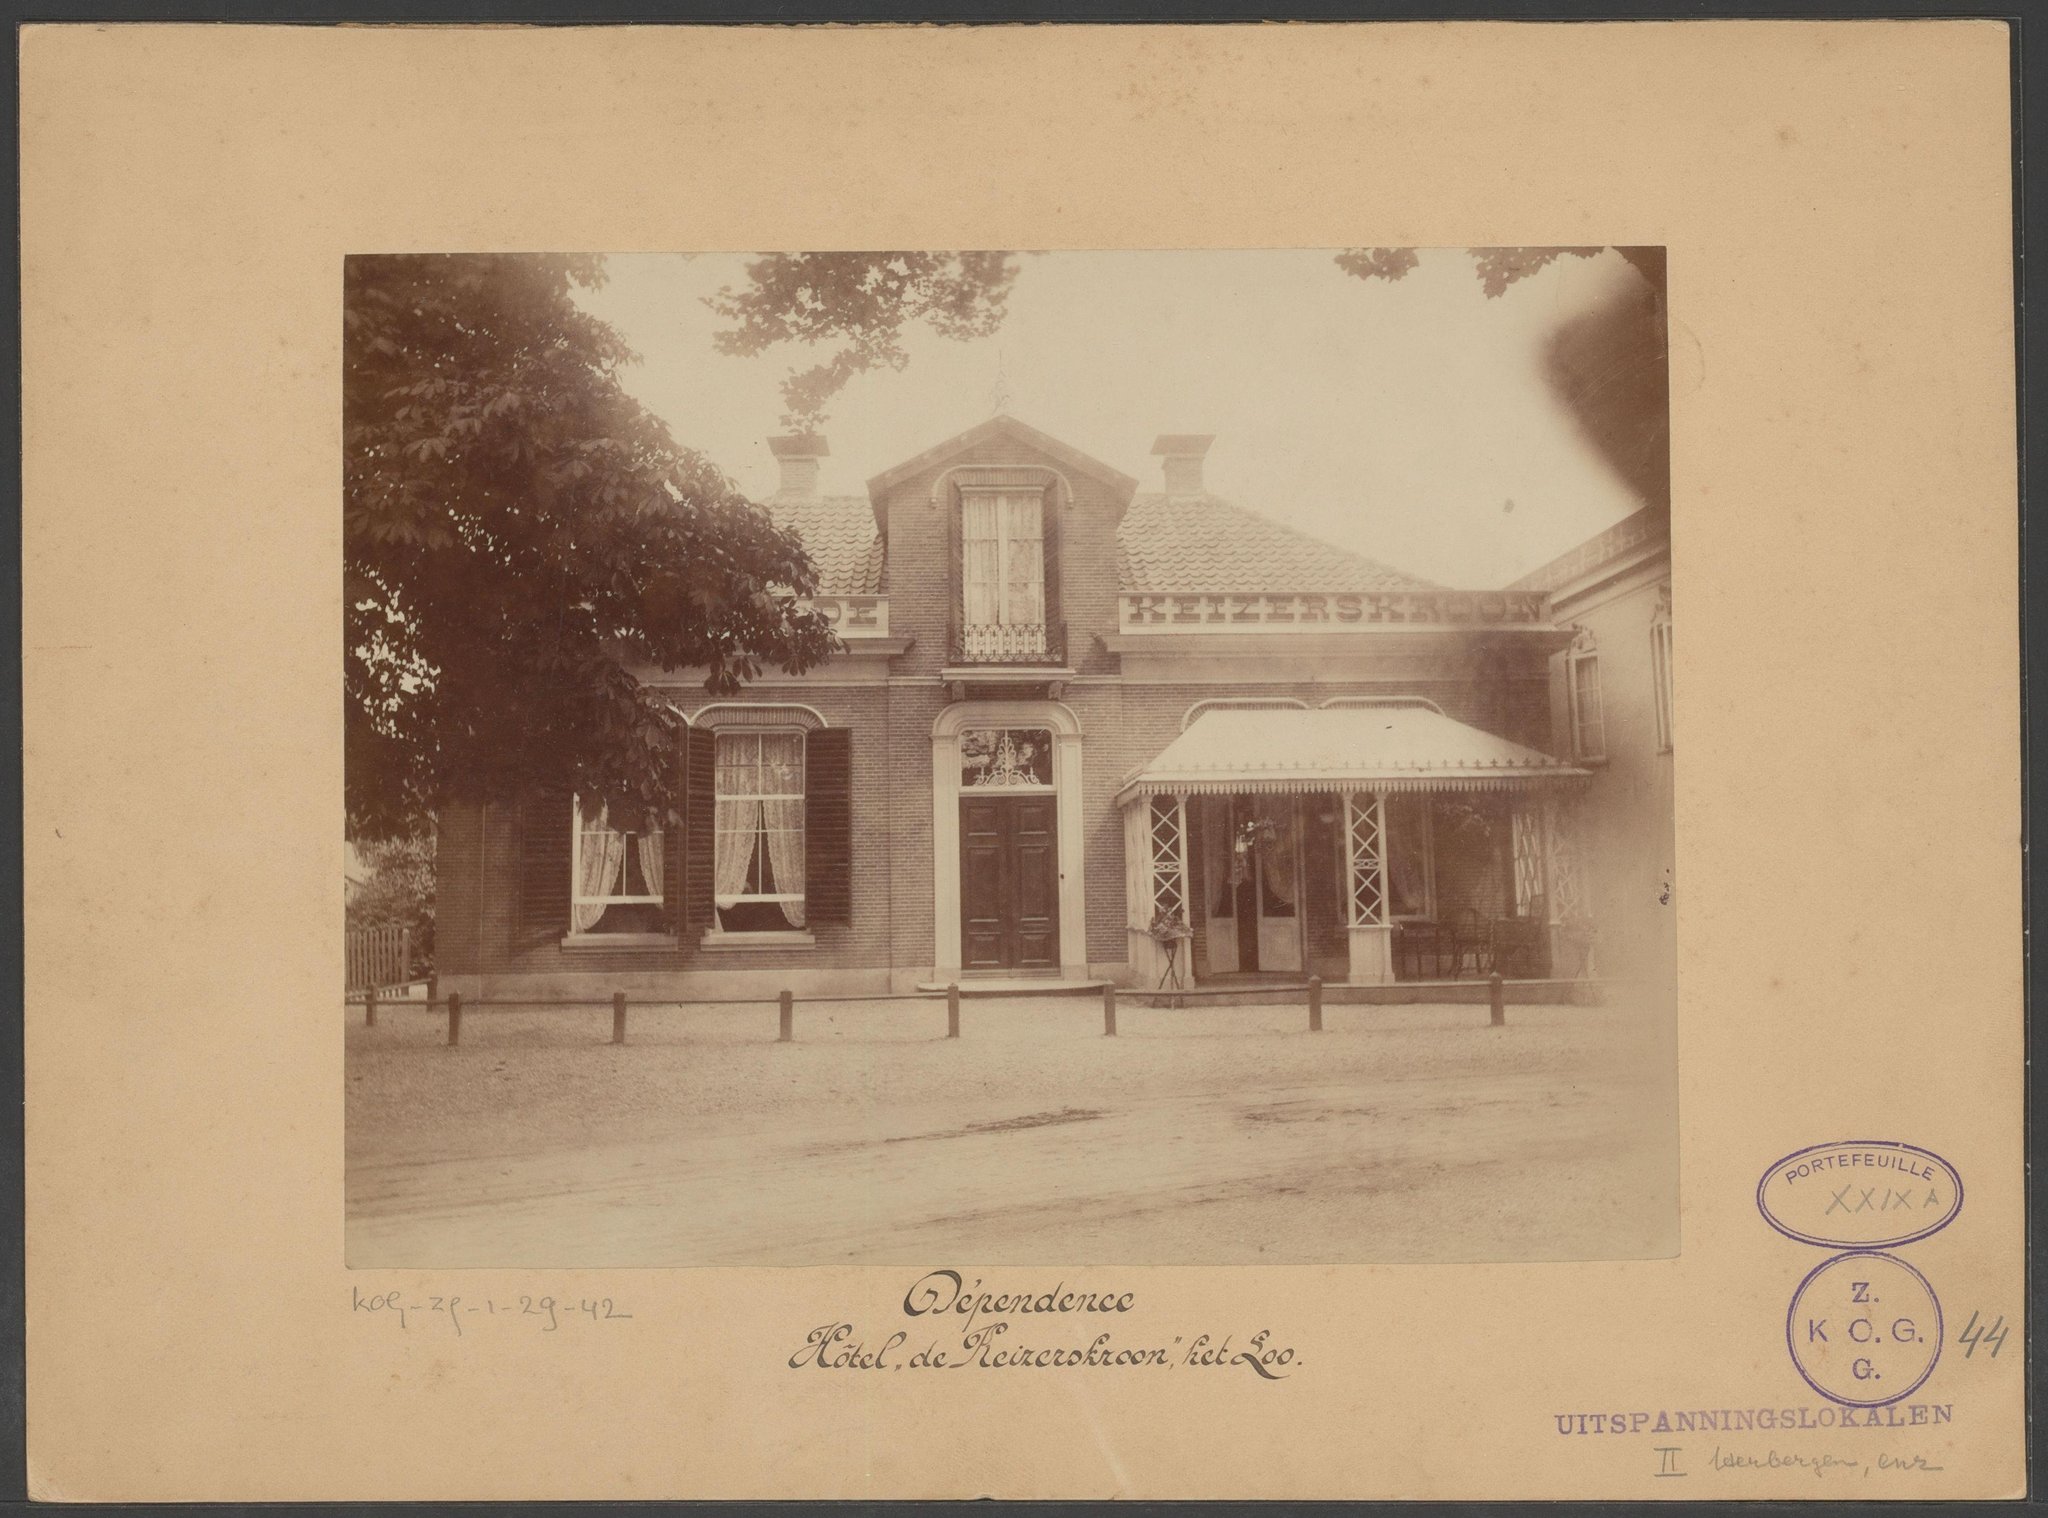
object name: print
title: Gezicht op de dependance het hotel De Keizerskroon in het Loo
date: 1881-1900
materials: photographic support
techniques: albumen print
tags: hotel, hostelry, inn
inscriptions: stamp, stamp, collector's mark: Lugt 1641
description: Onderwerpsrubrieken binnen de Atlas Zeden en Gewoonten: Zeden en gewoonten in engeren zin, Volksleven, Uitspanningslokalen, Hotels.